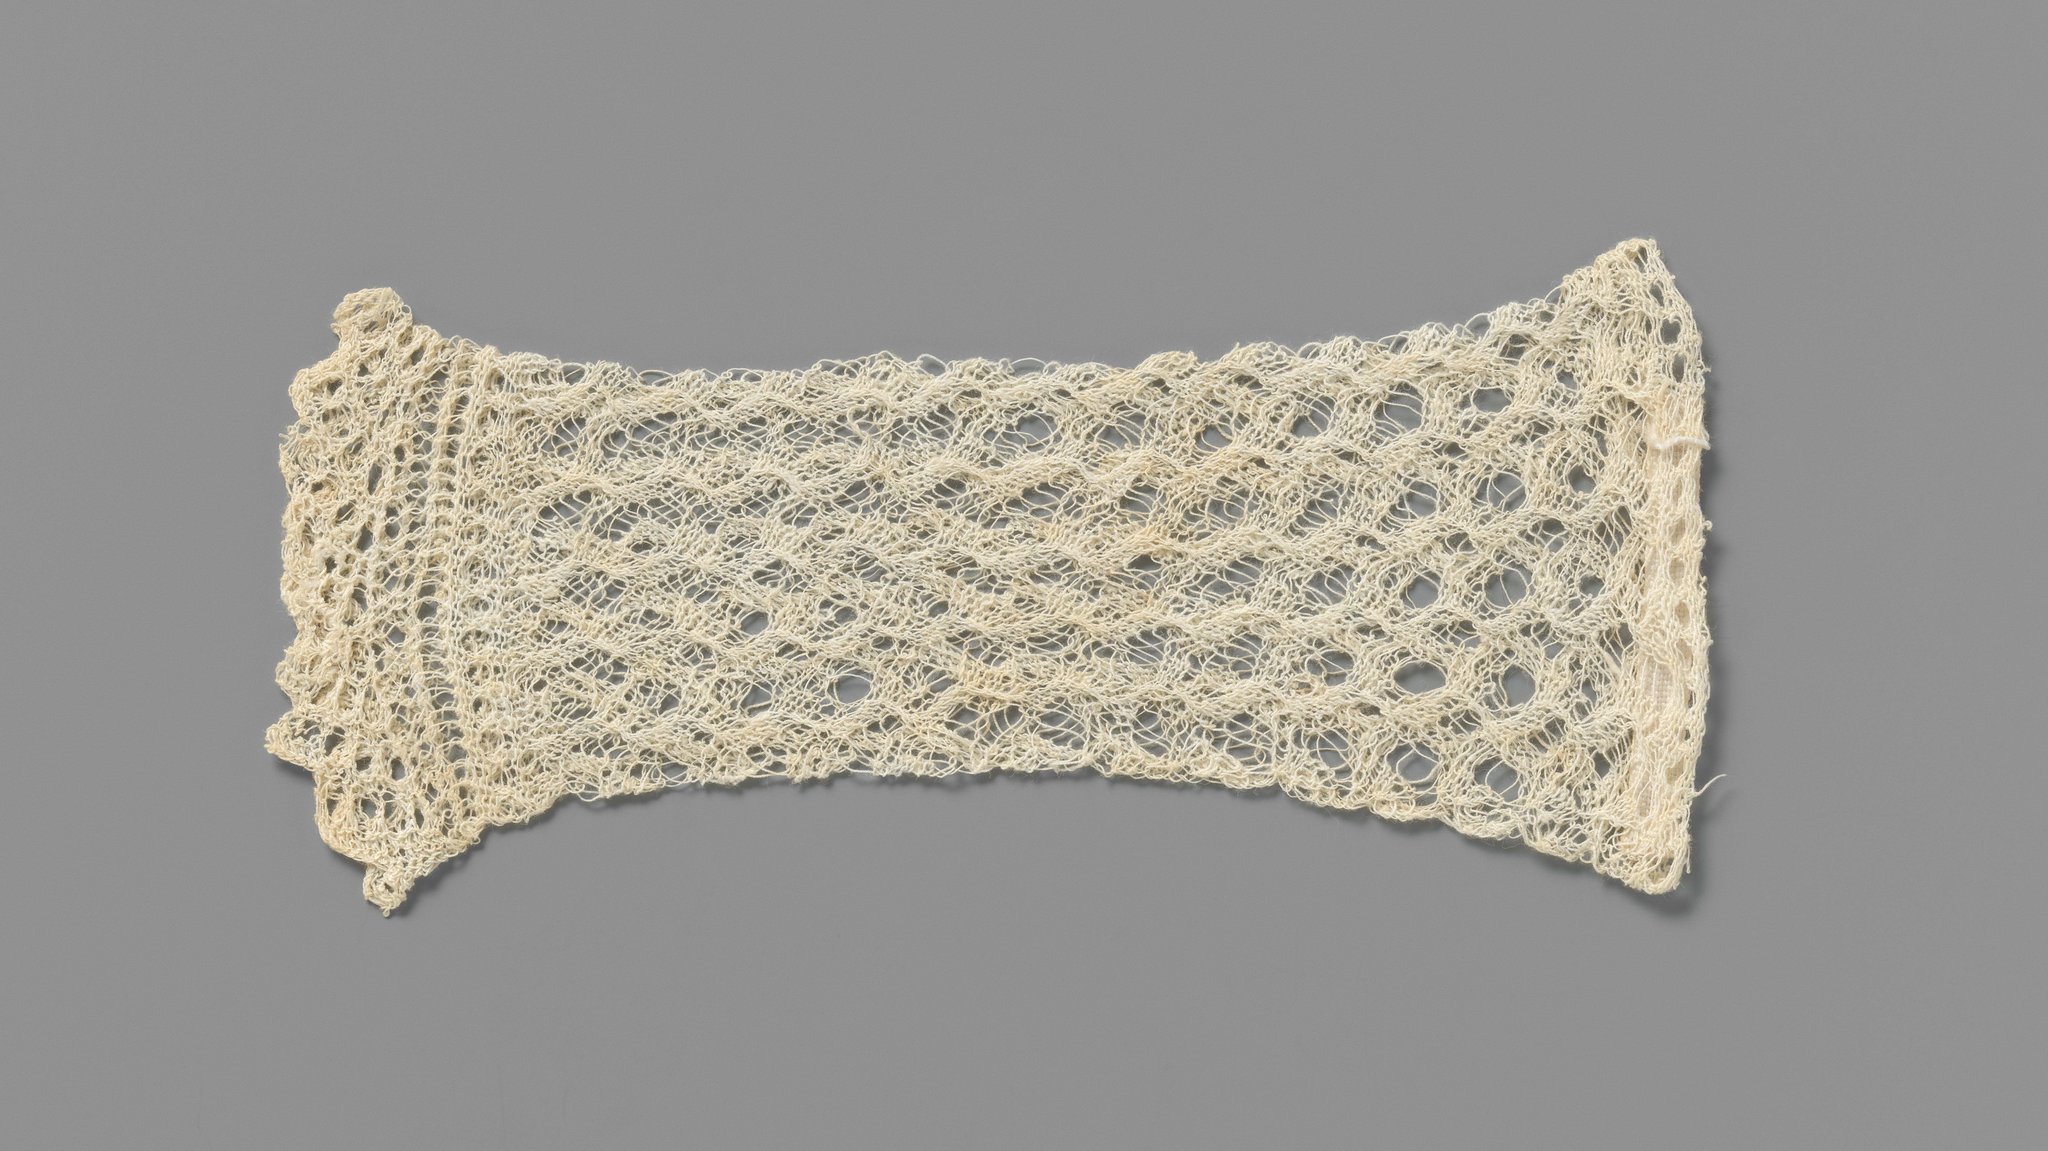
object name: childrenswear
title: Mitaine van wit katoen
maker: Anonymous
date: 1800-1825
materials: cotton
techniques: embroidery, knitting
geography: netherlands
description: Mitaine van wit katoen, ajour gebreid, voor baby of kind, zogenaamd Fries kant.